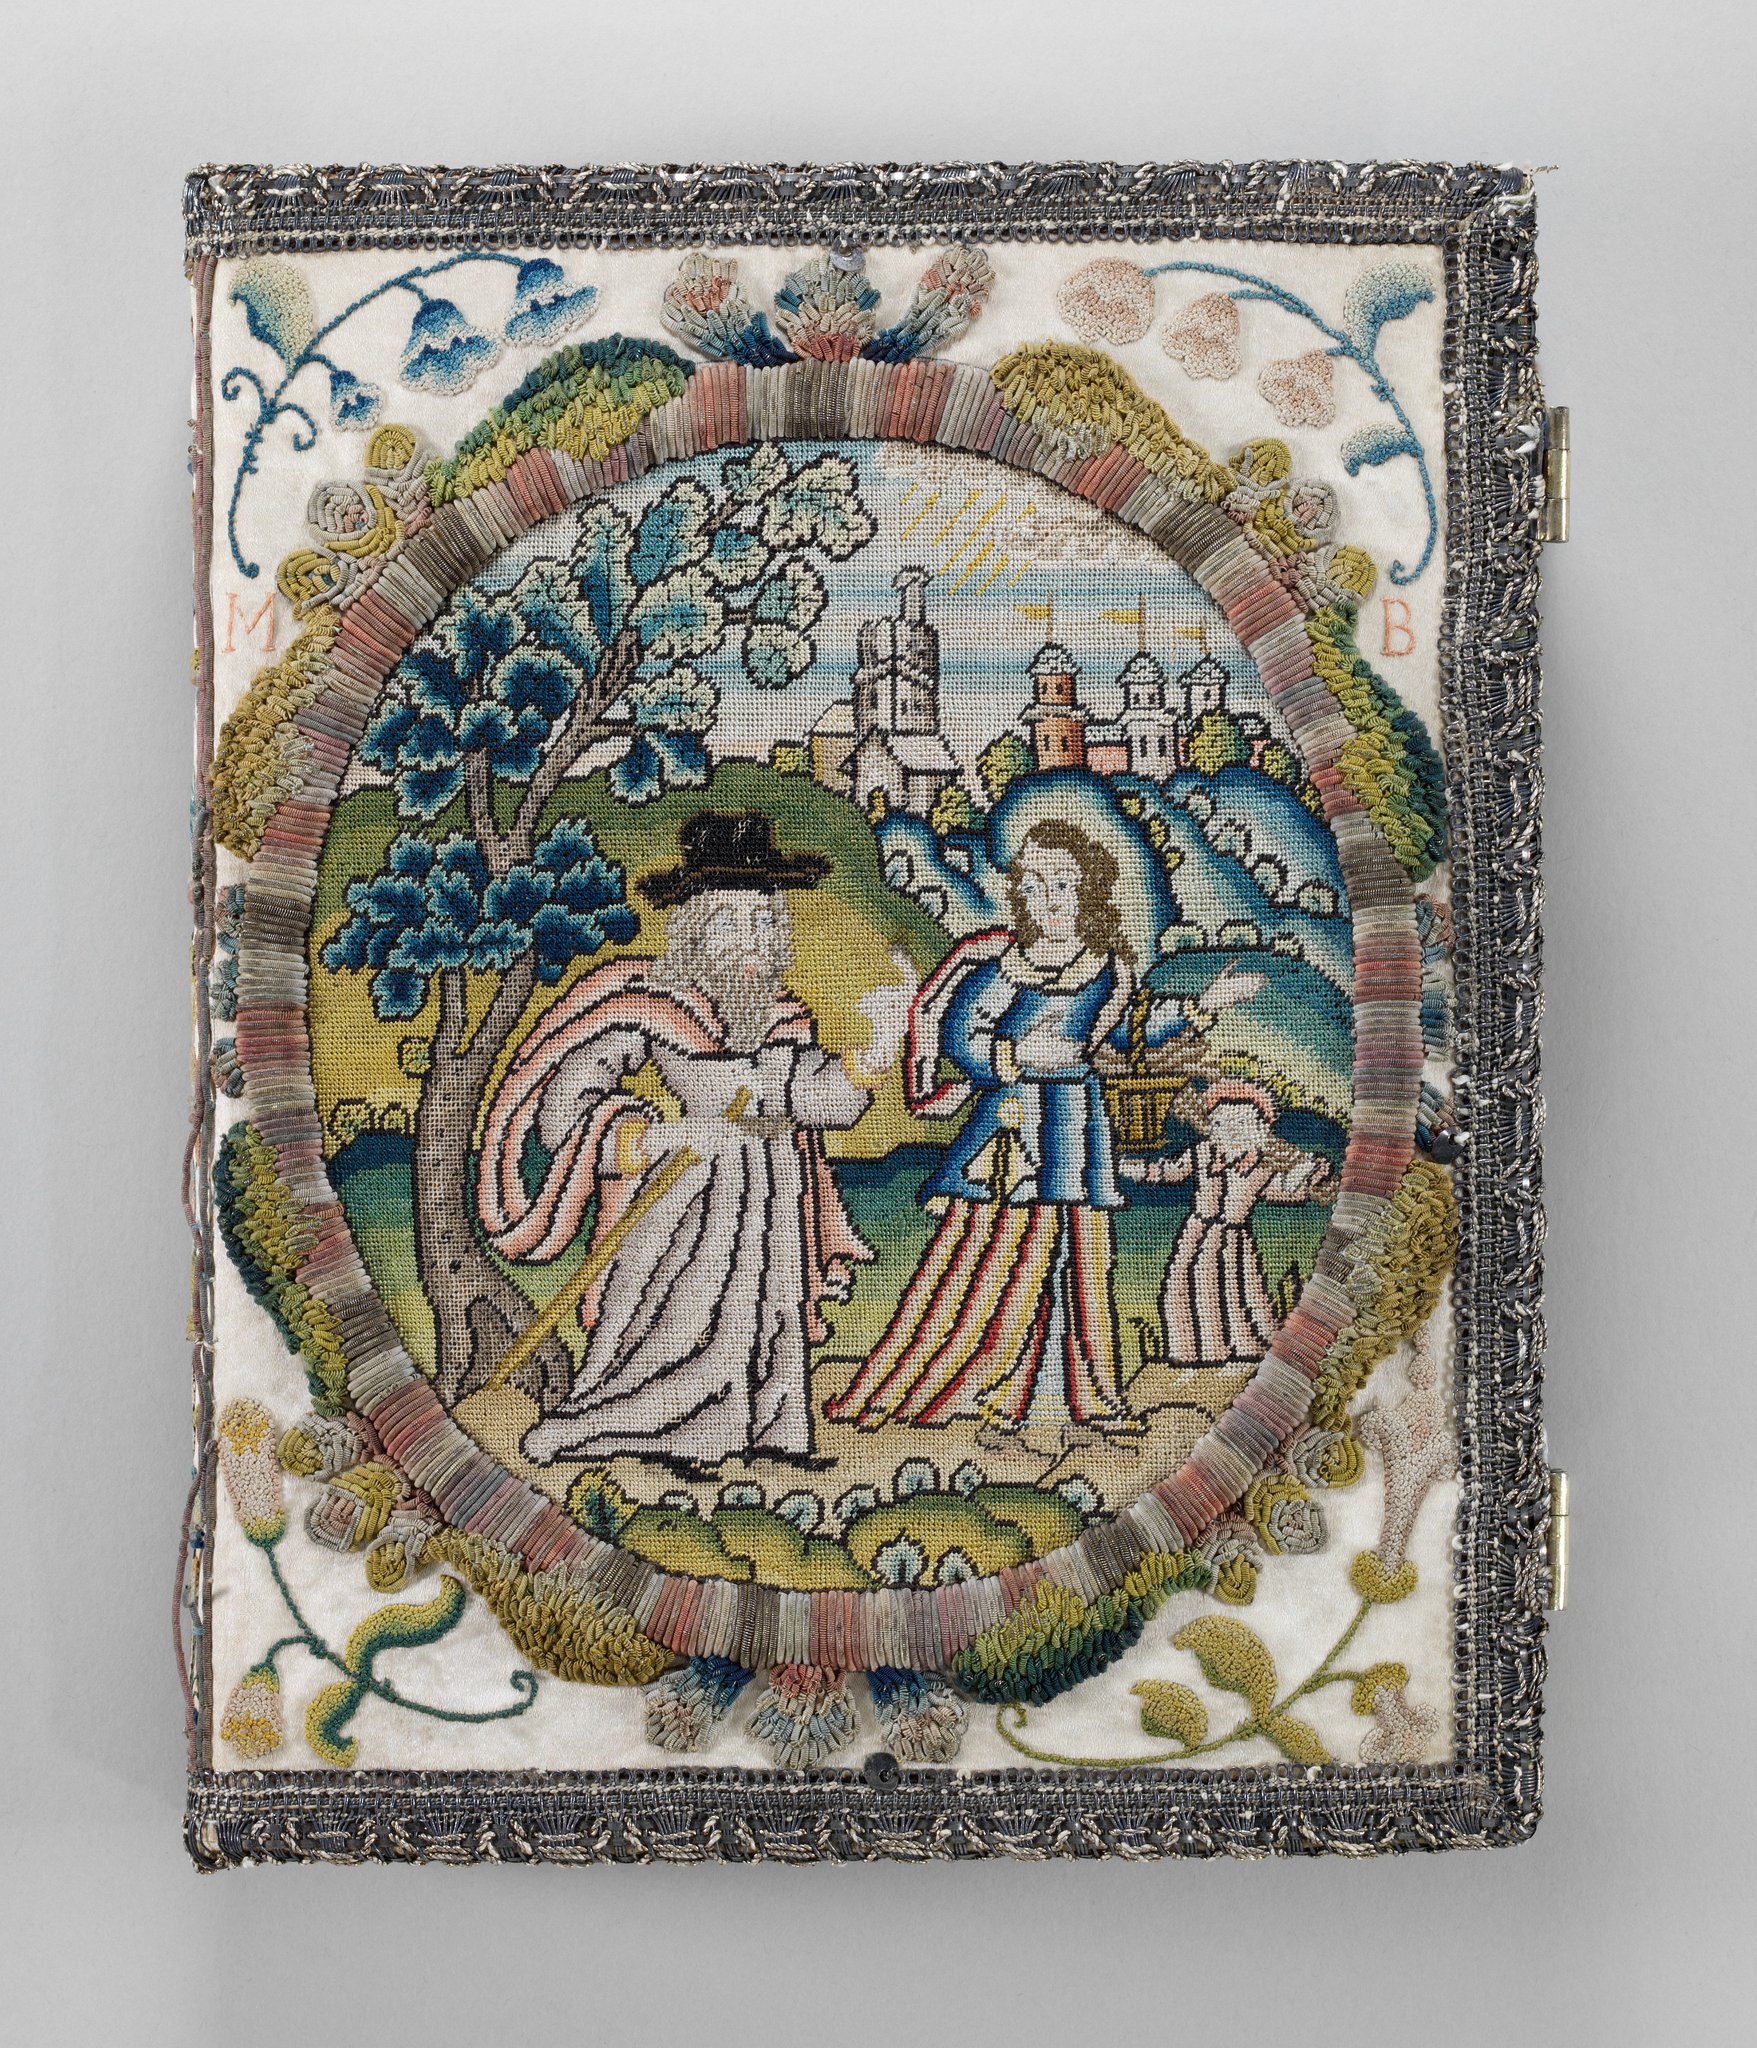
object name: book cover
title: The Bible, The Book of Psalms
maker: company of stationers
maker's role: printer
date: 1649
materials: metal thread, textile, silk, silver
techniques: embroidery, stitching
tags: men,women,bible